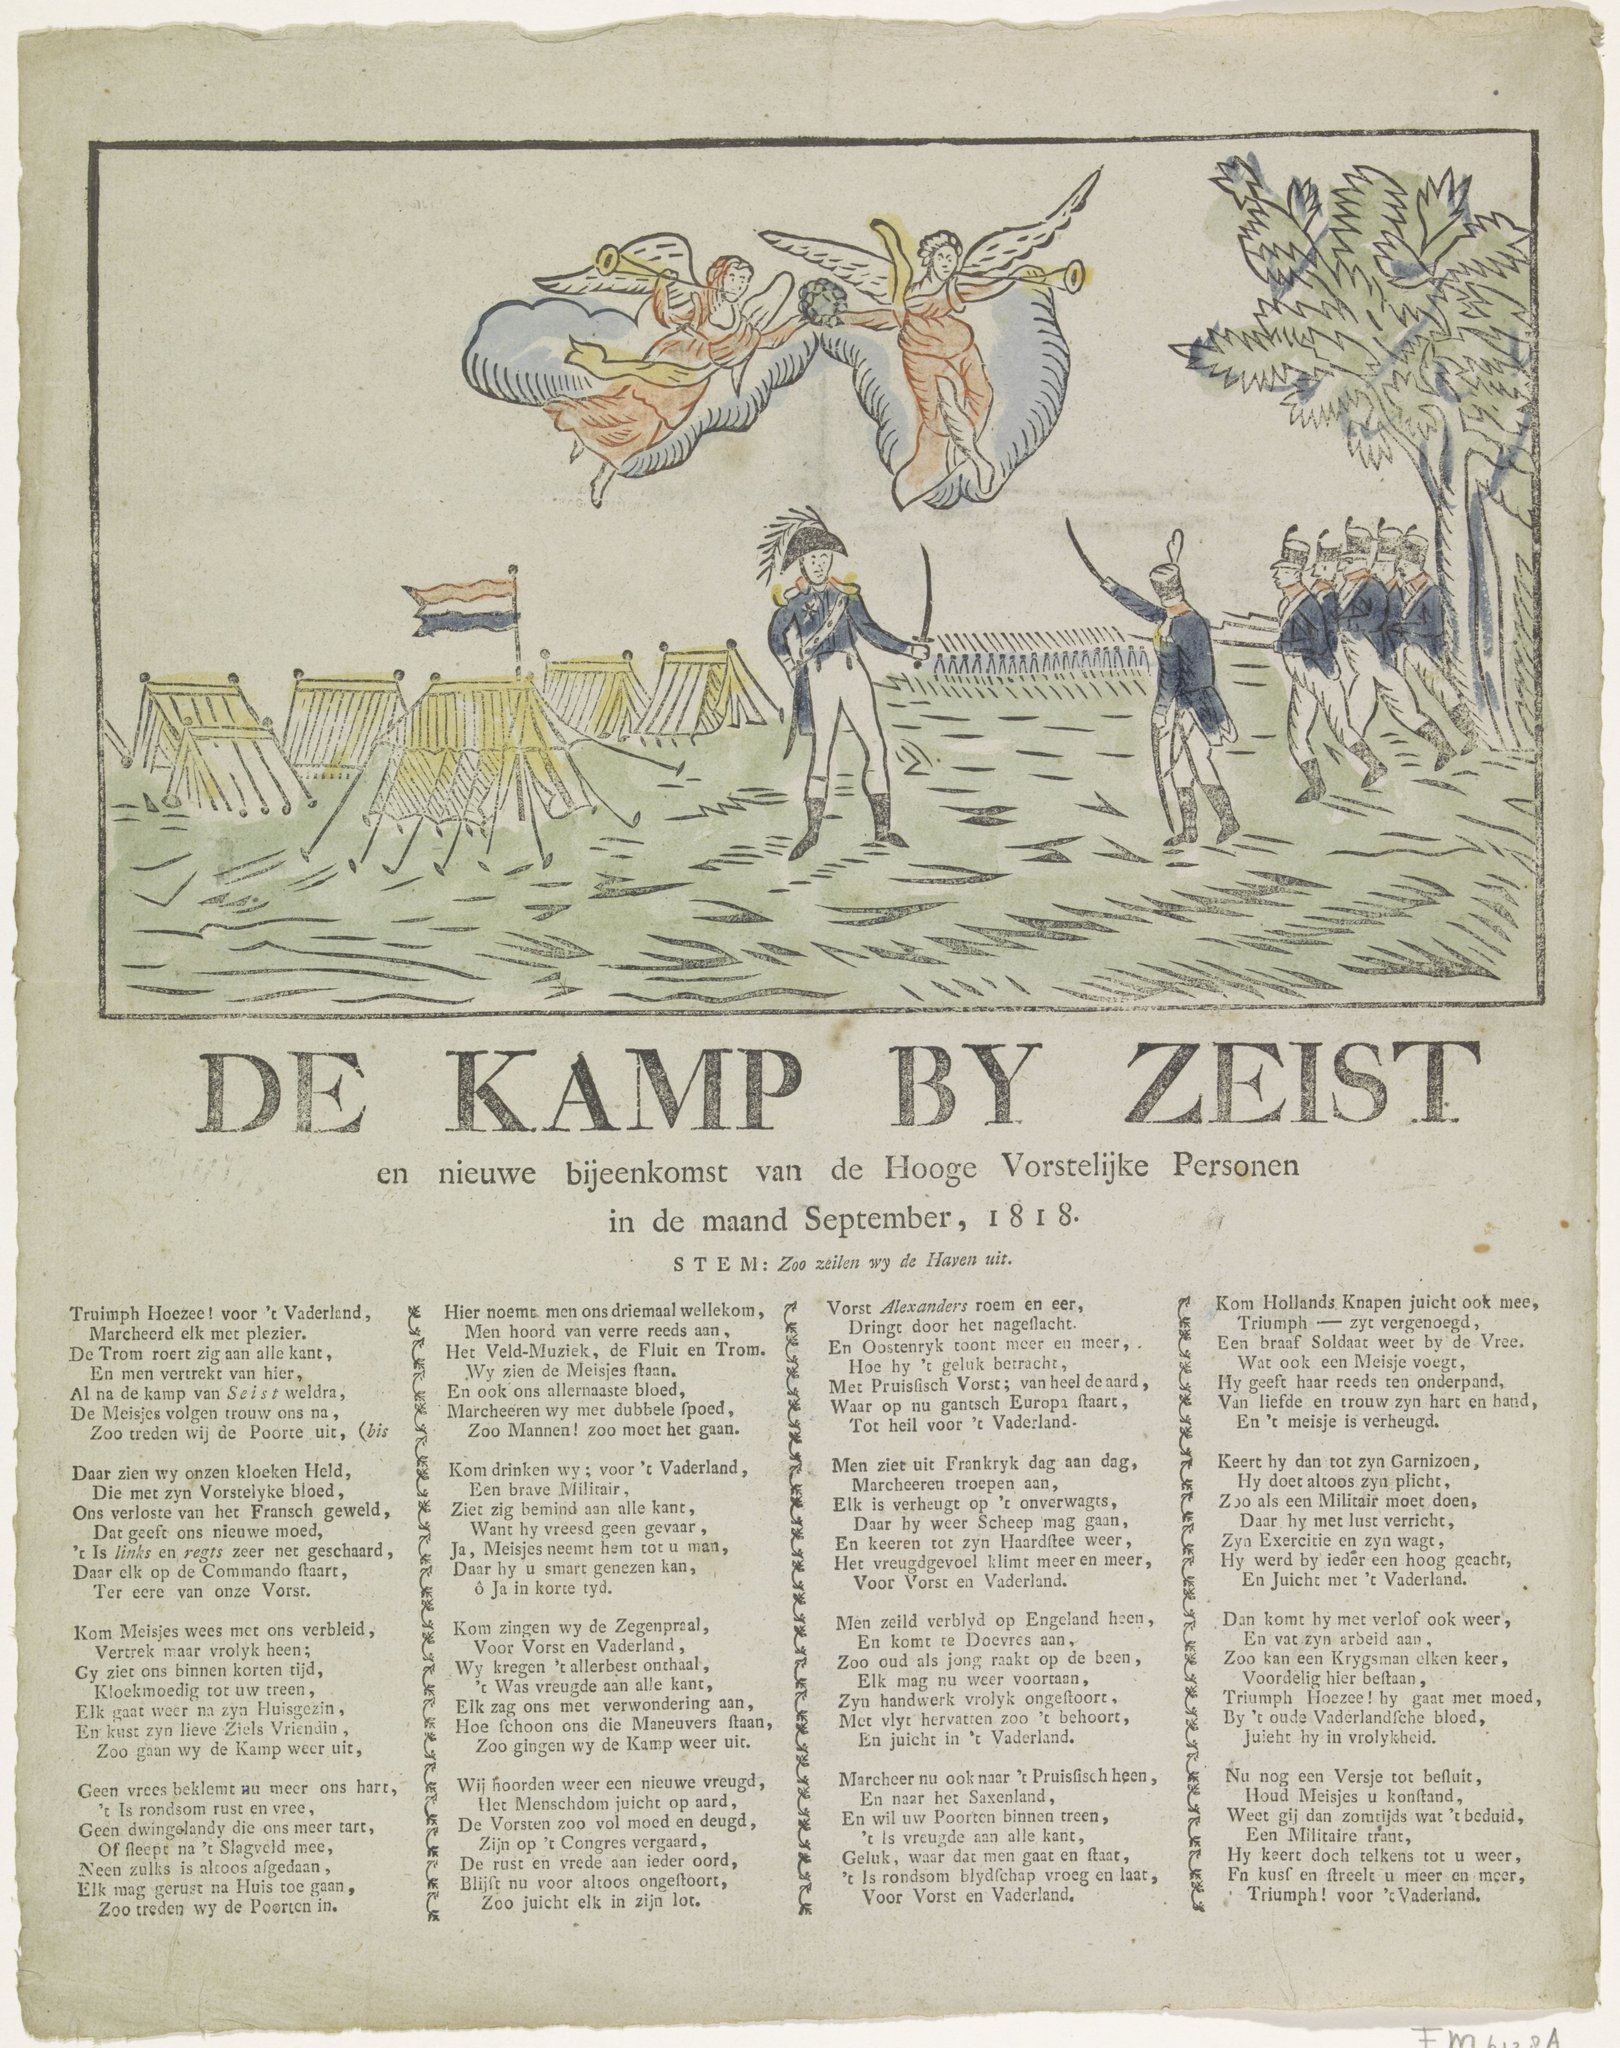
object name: print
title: De Kamp by Zeist en nieuwe bijeenkomst van de Hooge Vorstelijke Personen in de maand September, 1818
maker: Anonymous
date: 1818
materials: paper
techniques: hand coloring, letterpress printing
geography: netherlands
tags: the hague, william ii of the netherlands, (military) camp with tents, fame; 'fama', 'fama buona', 'fama chiara' (ripa), zeist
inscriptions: collector's mark: Lugt 2228, collector's mark: Lugt 2760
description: Het kamp van het Nederlandse leger bij Zeist, in september 1818. Militairen oefenen op een terrein bij een legerkamp. In de lucht twee engelen met bazuinen die een lauwerkrans houden boven het hoofd van een militaire bevelhebber, volgens de tekst van het lied moet het gaan om de prins van Oranje. De ondertitel verwijst naar de bijeenkomst van vorsten op het congres van Wenen. Op het blad onder de voorstelling een lied in zestien coupletten in vier kolommen.